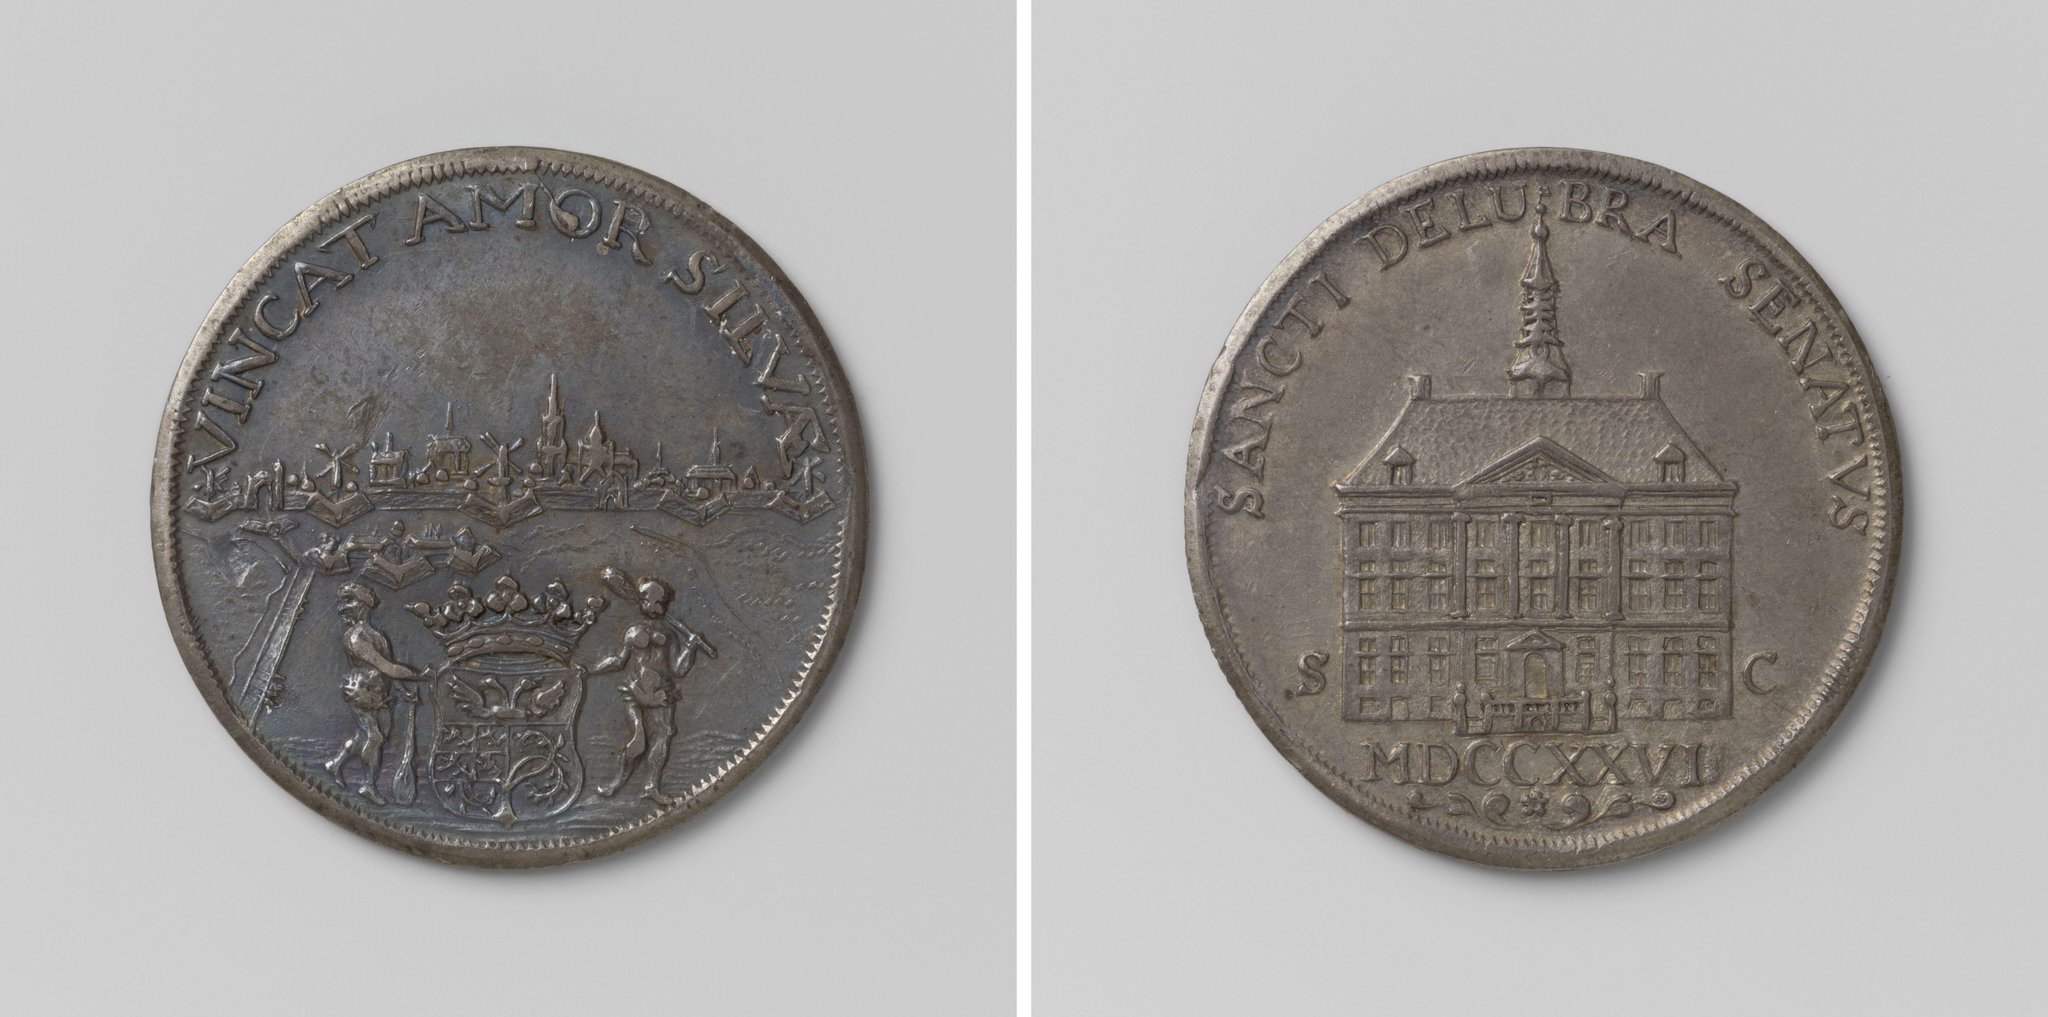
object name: council medal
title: Vroedschapspenning van de stad 's-Hertogenbosch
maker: theodorus casparus van berckel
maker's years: 1680-1734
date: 1727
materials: silver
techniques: striking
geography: den bosch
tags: den bosch